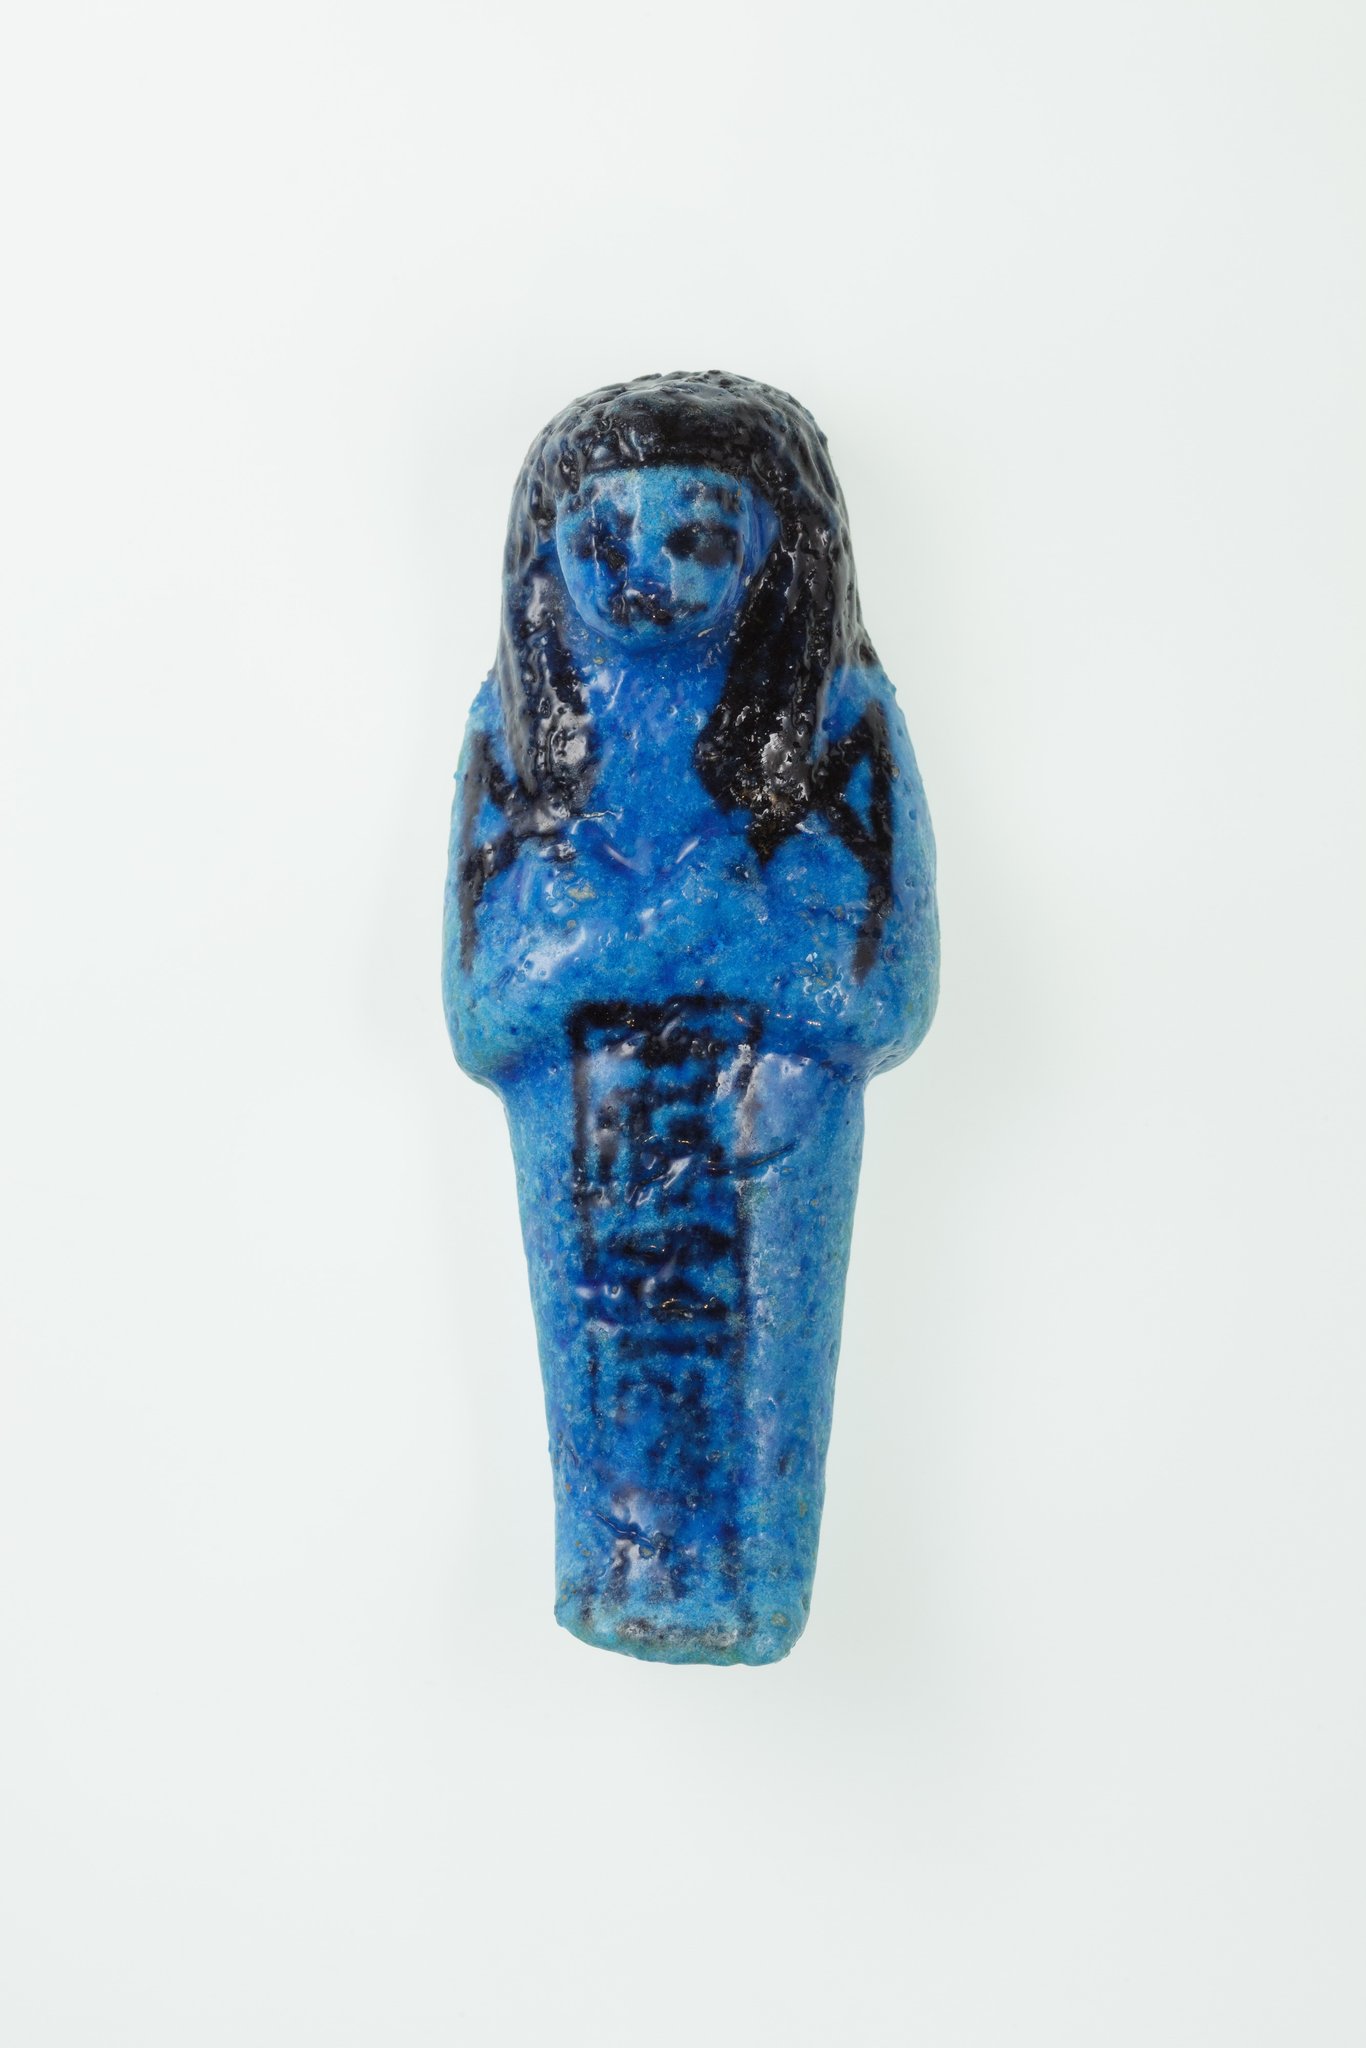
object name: shabti, worker, nauny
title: Worker Shabti of Nauny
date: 1050 BCE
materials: faience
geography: egypt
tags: hieroglyphs